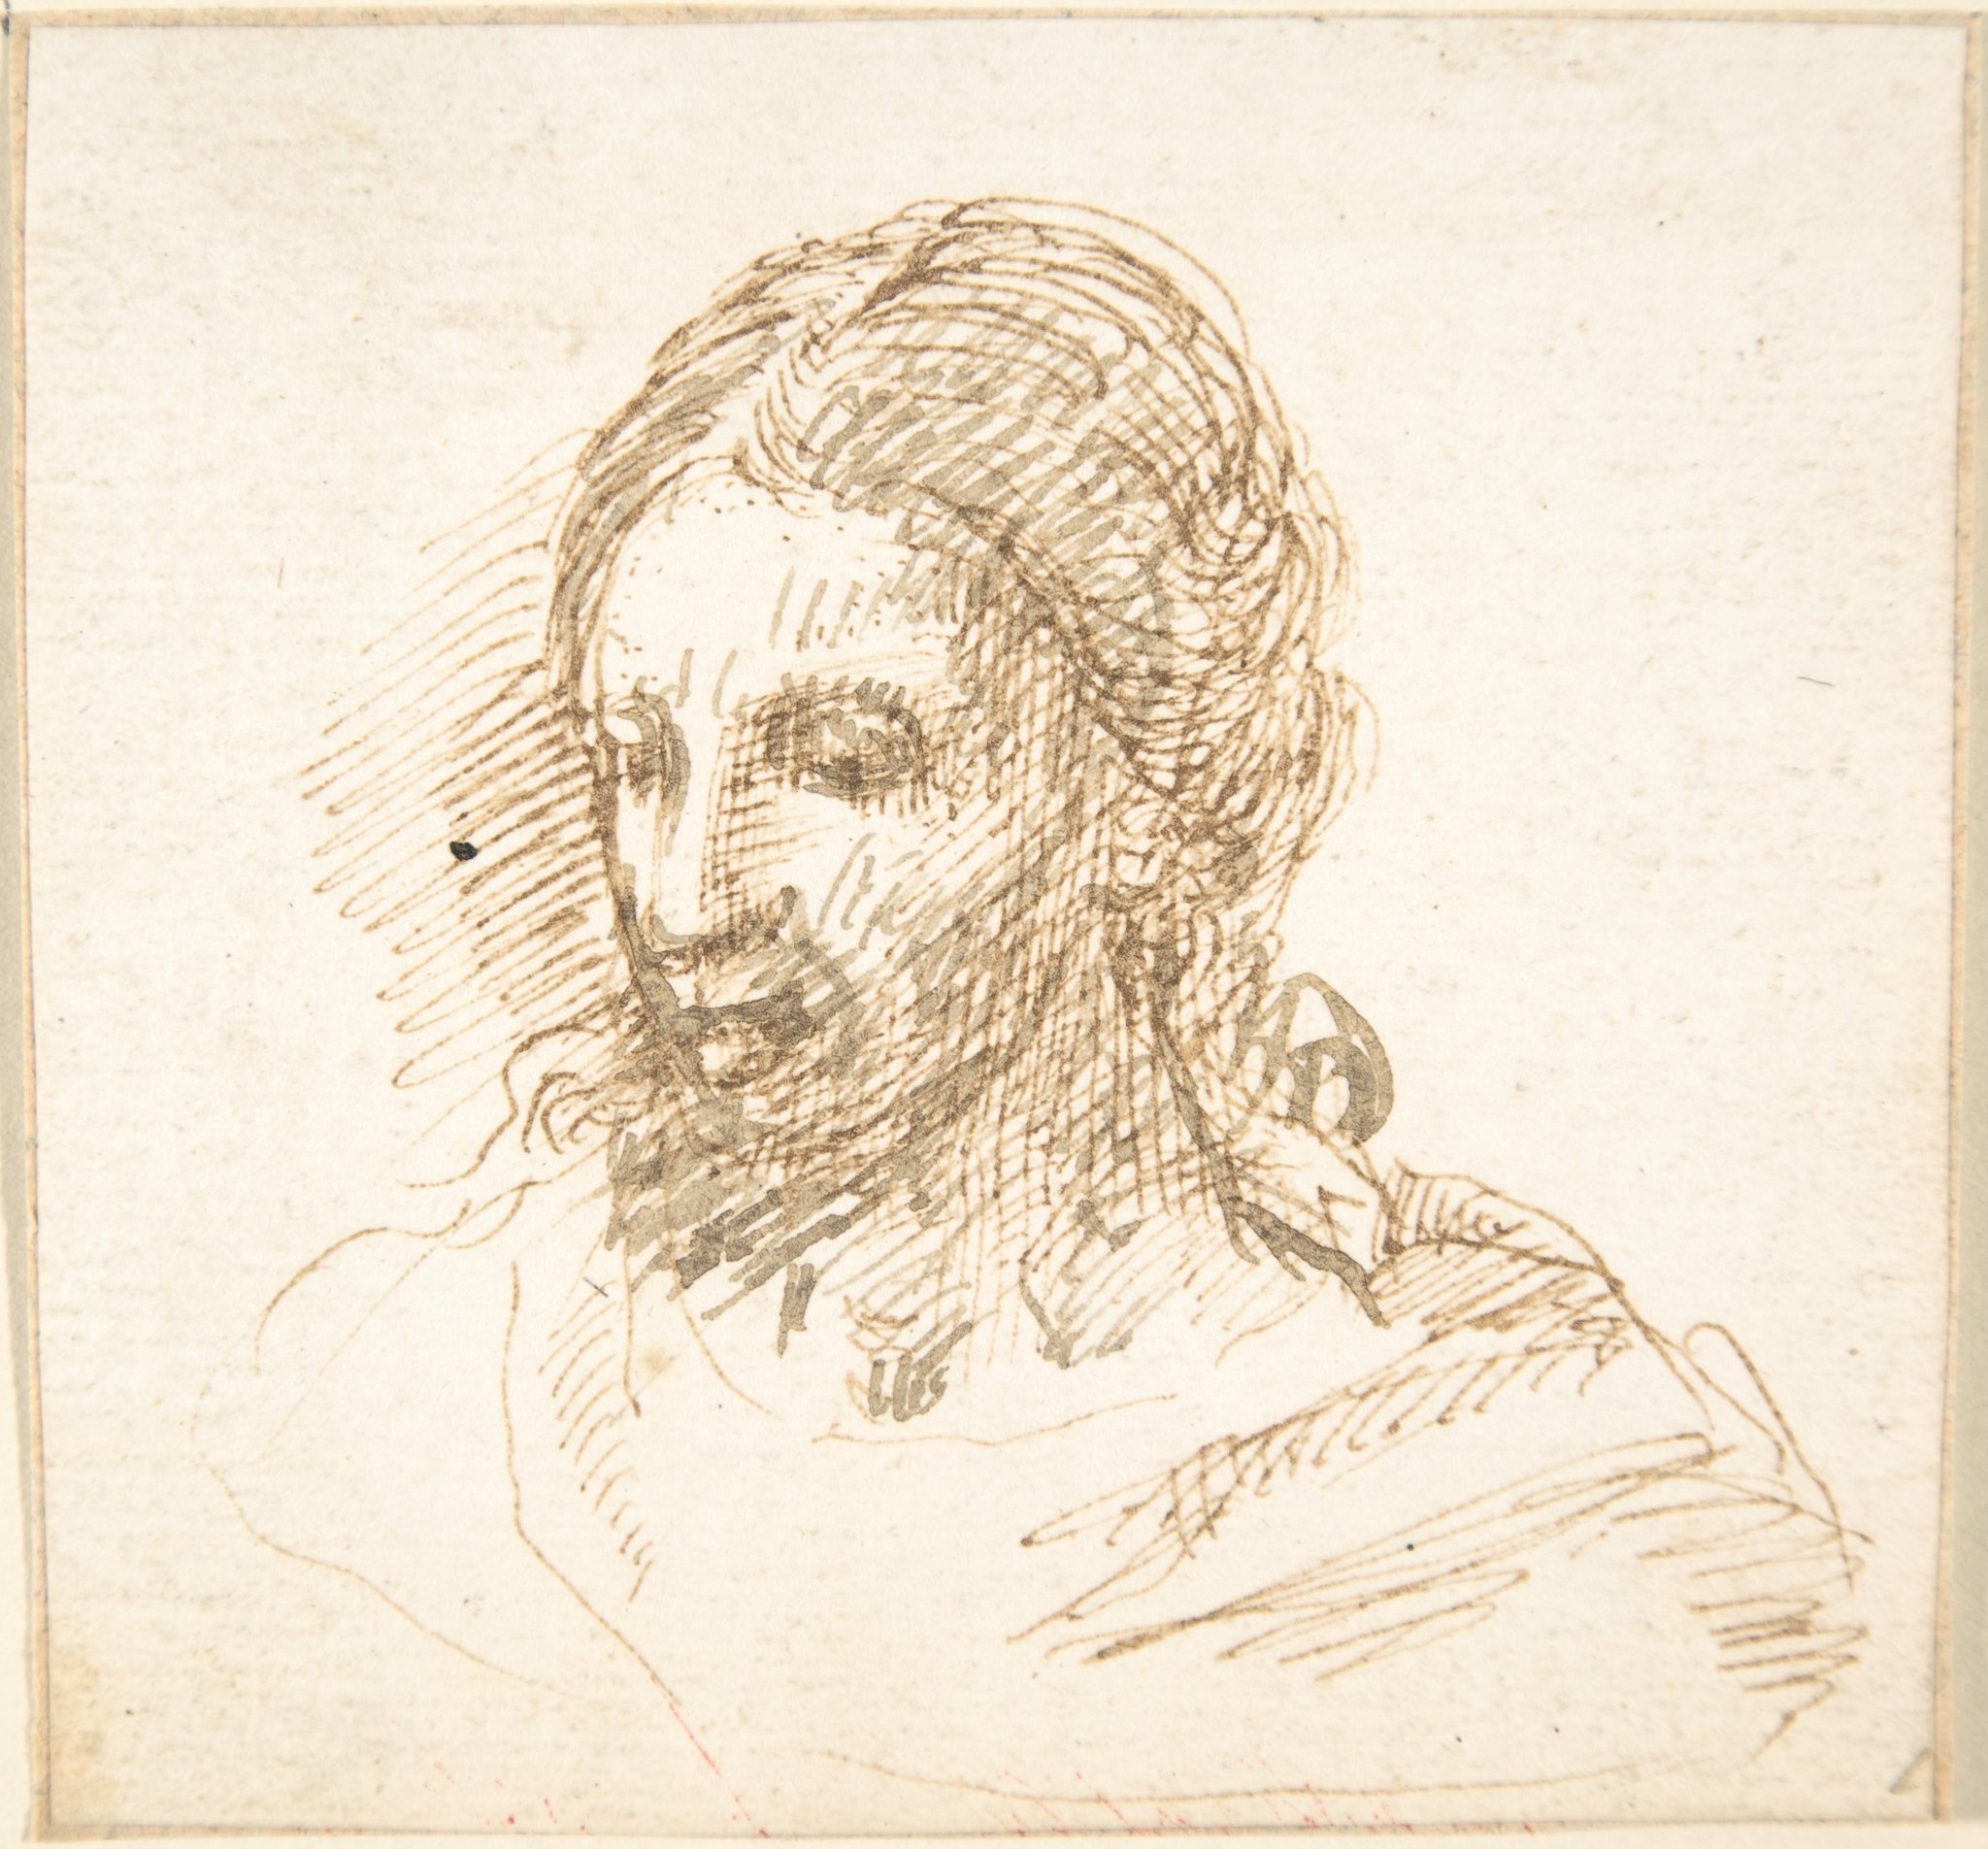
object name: drawing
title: Head of Christ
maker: pedro duque cornejo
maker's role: artist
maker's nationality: spanish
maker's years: 1677-1757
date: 1700-1750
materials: ink, paper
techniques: pen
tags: heads,jesus